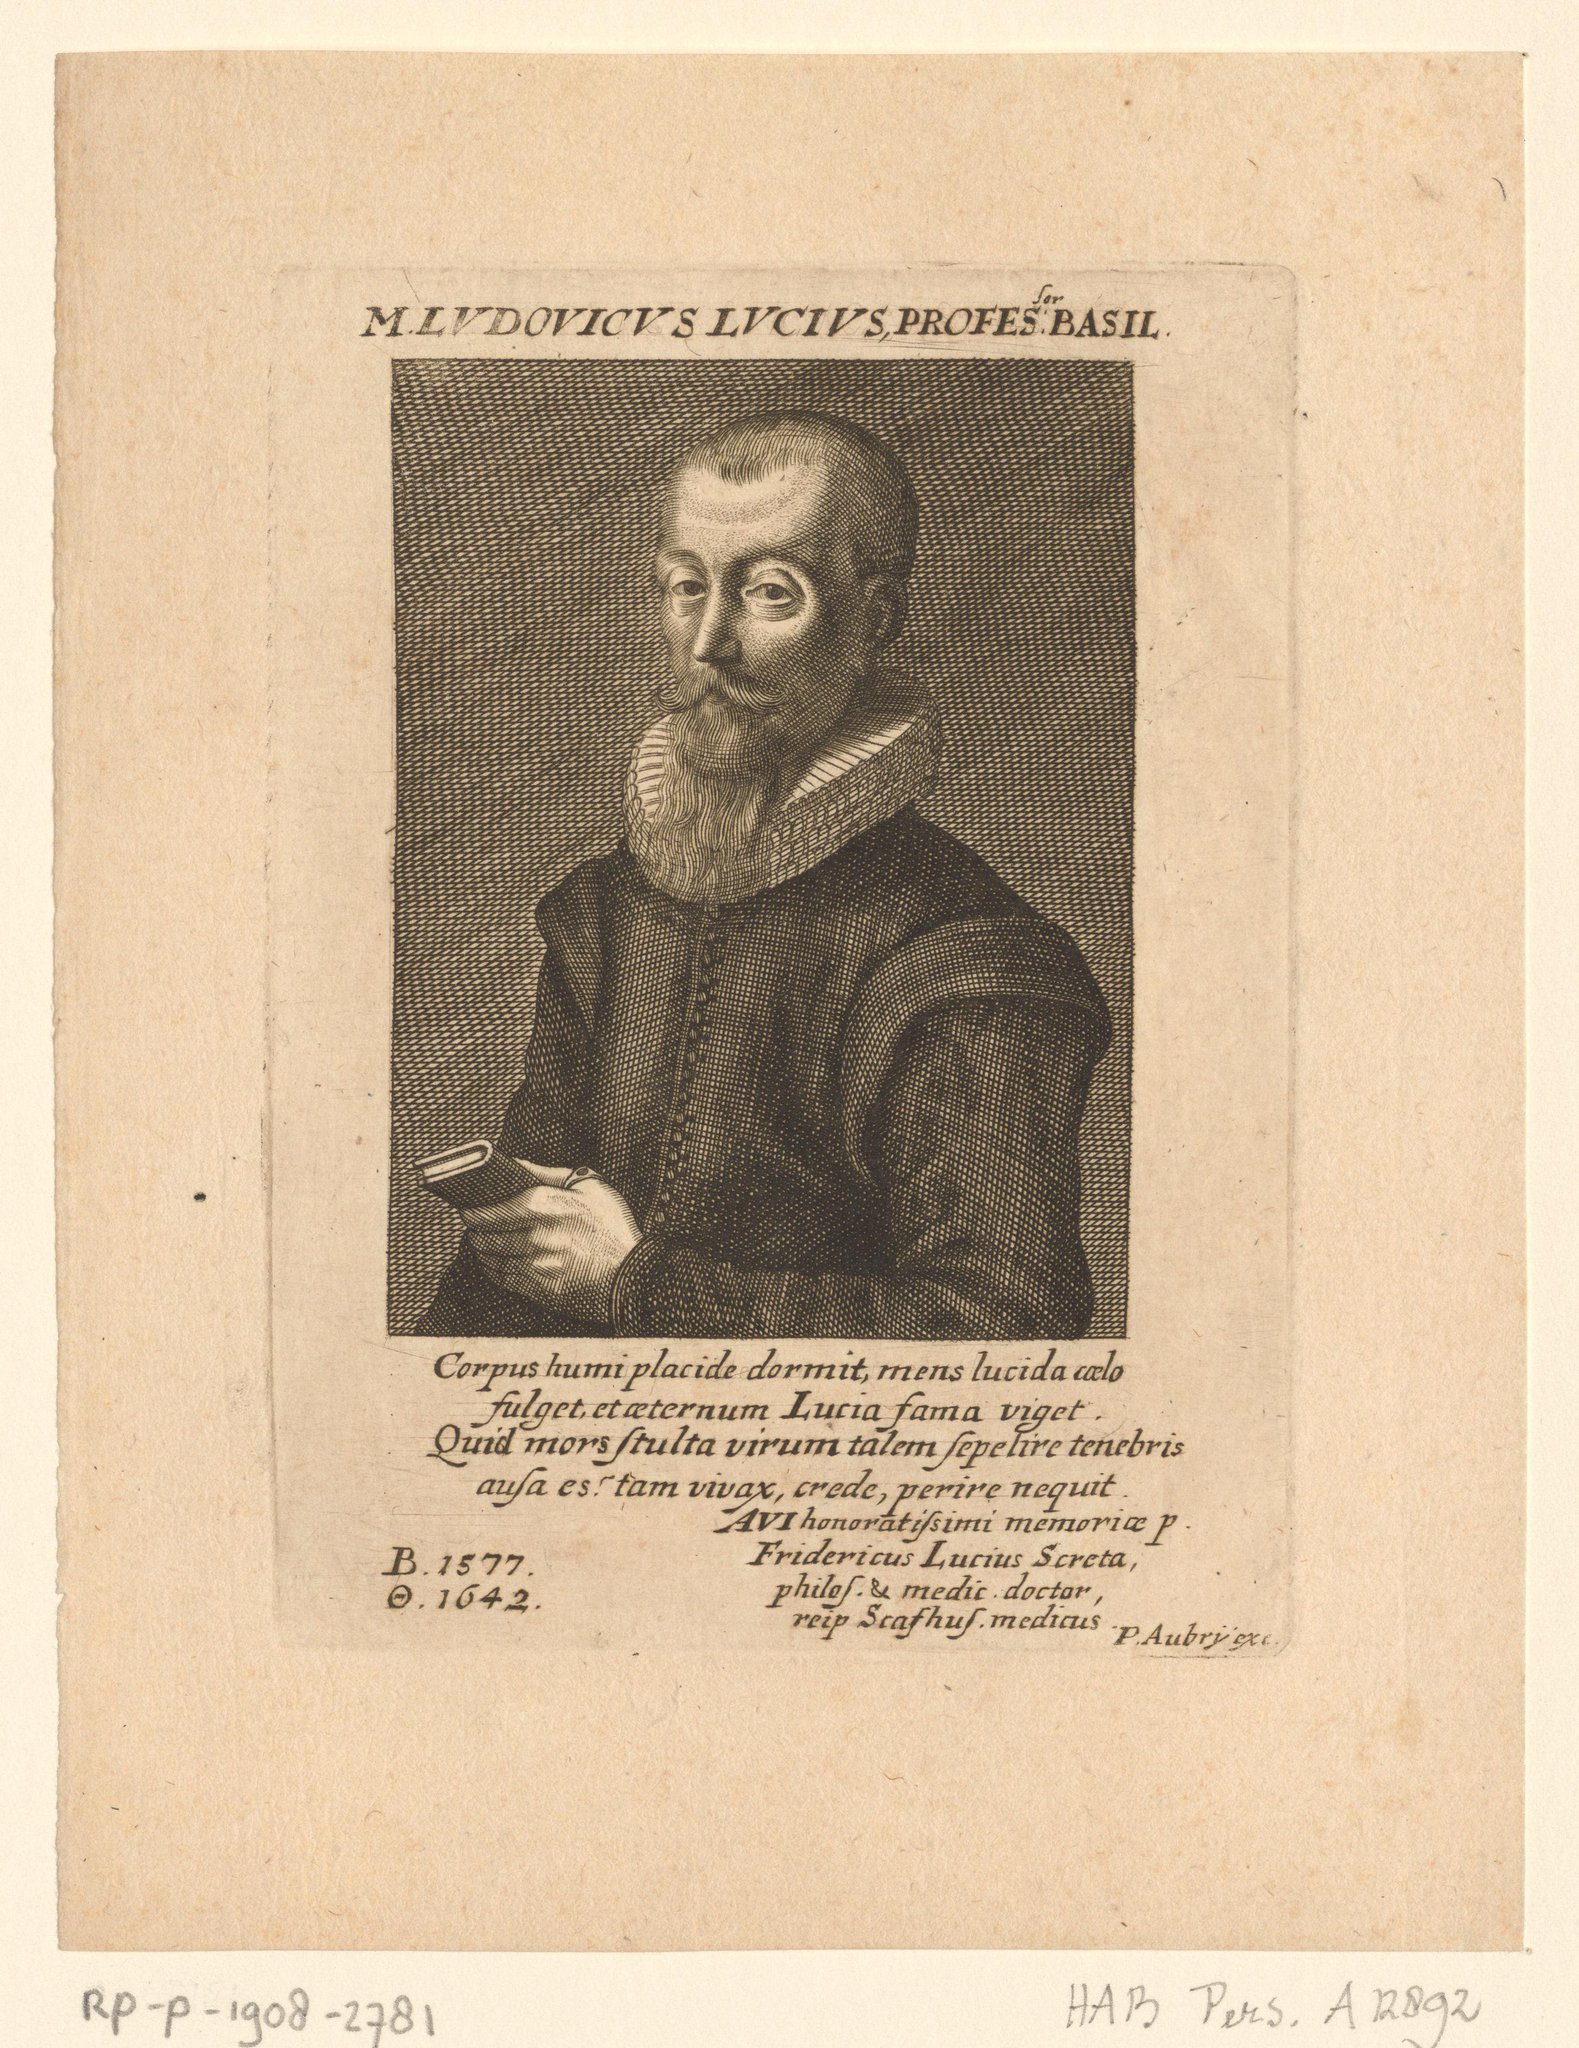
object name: print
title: Portret van Ludwig Lucius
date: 1642-1666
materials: paper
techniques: engraving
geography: straatsburg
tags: theologian, historical persons, book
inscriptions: collector's mark: Lugt 2228